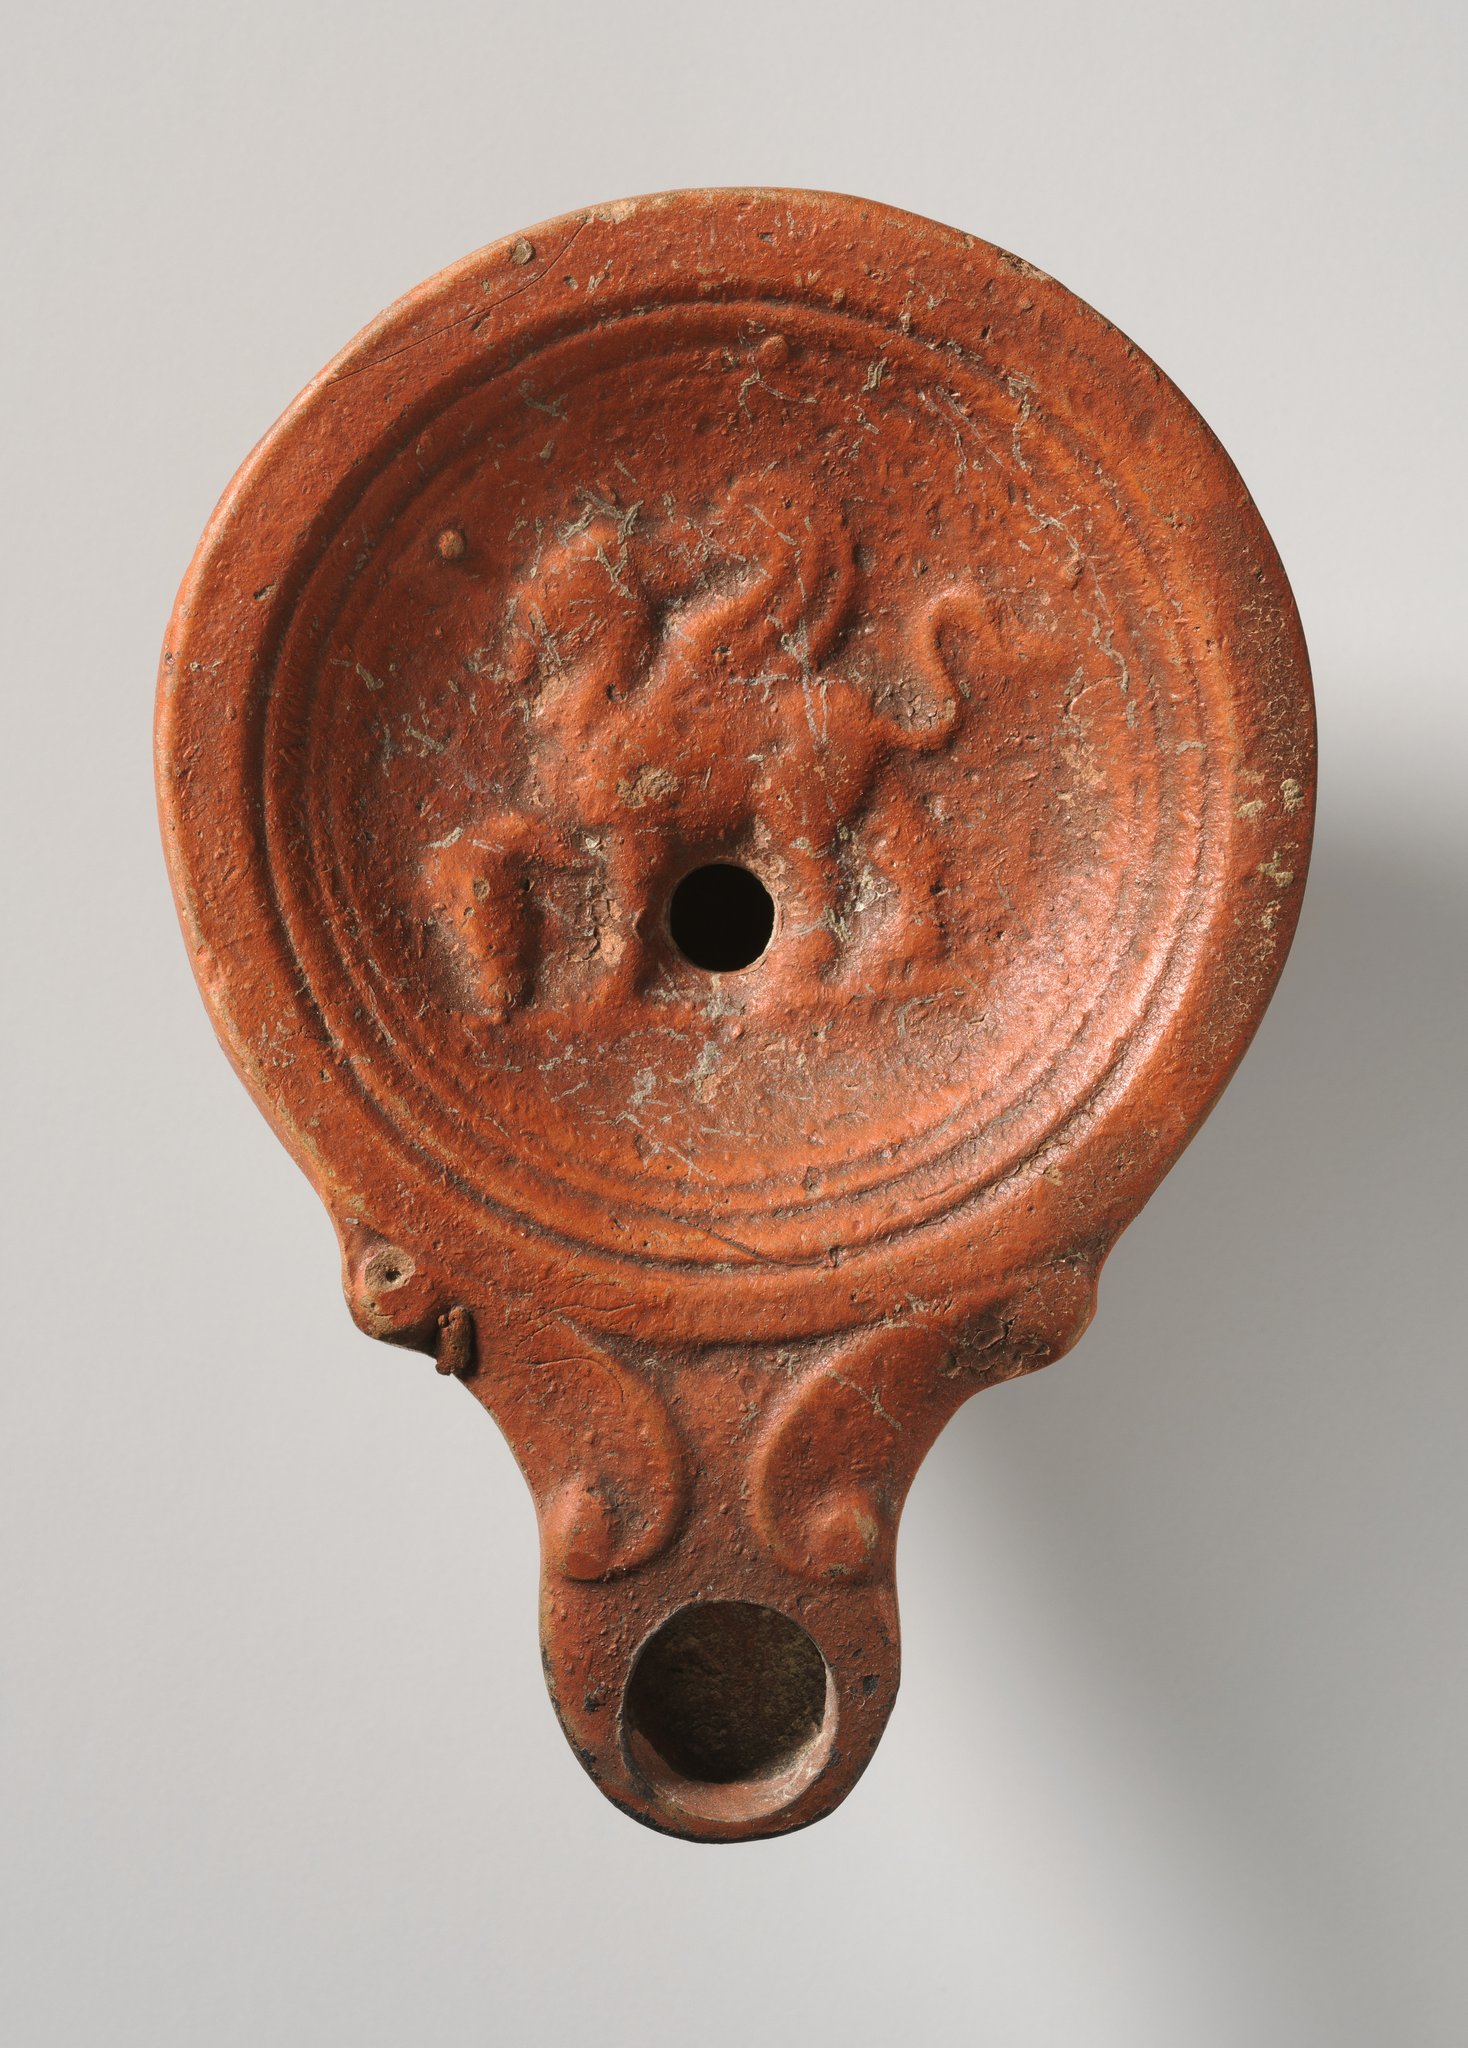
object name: lamp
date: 100 BCE-100 CE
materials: earthenware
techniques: molding